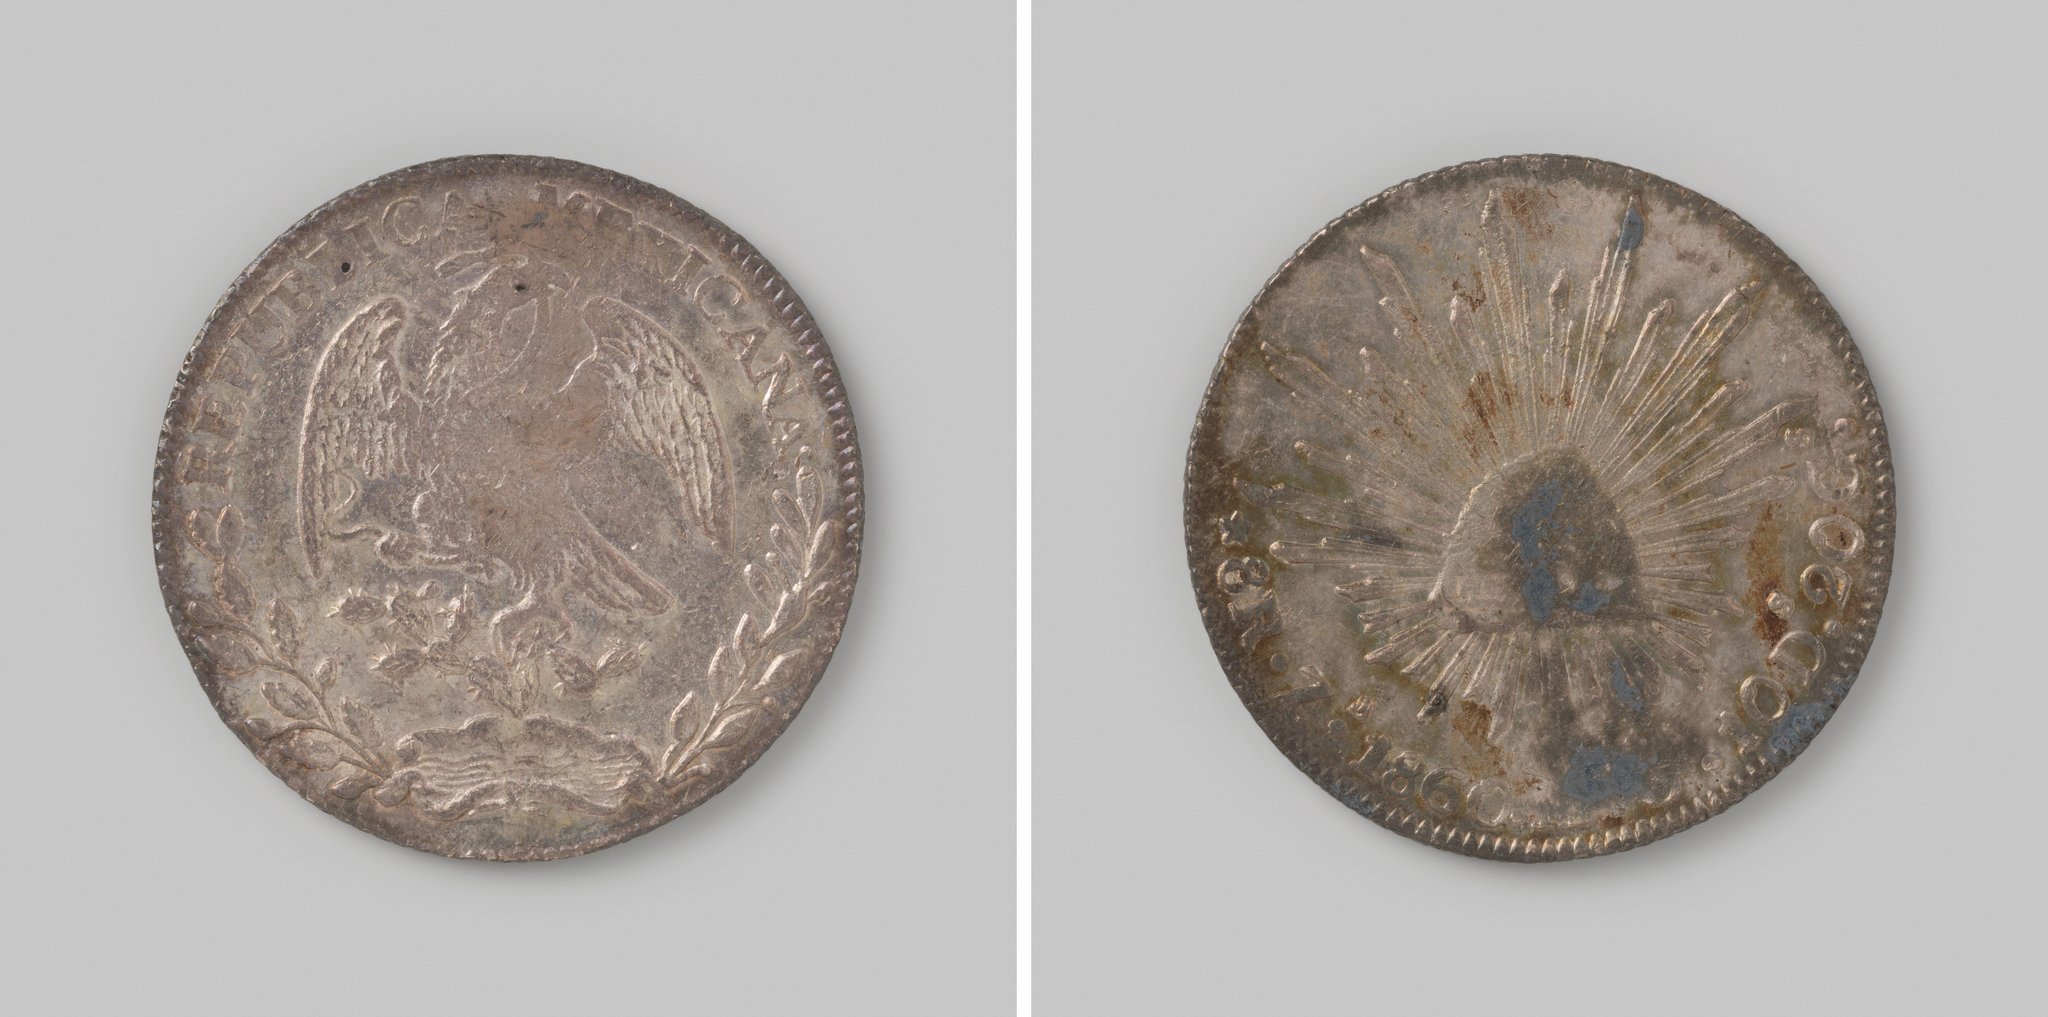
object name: peso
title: Peso of acht reaal uit Mexico (Zacatecas), 1860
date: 1860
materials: silver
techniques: striking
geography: zacatecas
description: Zilveren munt. Voorzijde: tussen twee samengebonden takken op cactusplant staande adelaar met gespreide vleugels met zijn kop naar rechts met in zijn bek een slang. Keerzijde: vrijheidshoed, waaruit stralen te voorschijn komen. In omschrift waarde-aanduiding: 8R en muntplaats-aanduiding: Zs [=Zacatecas] met jaartal linksonder. Kabelrand.